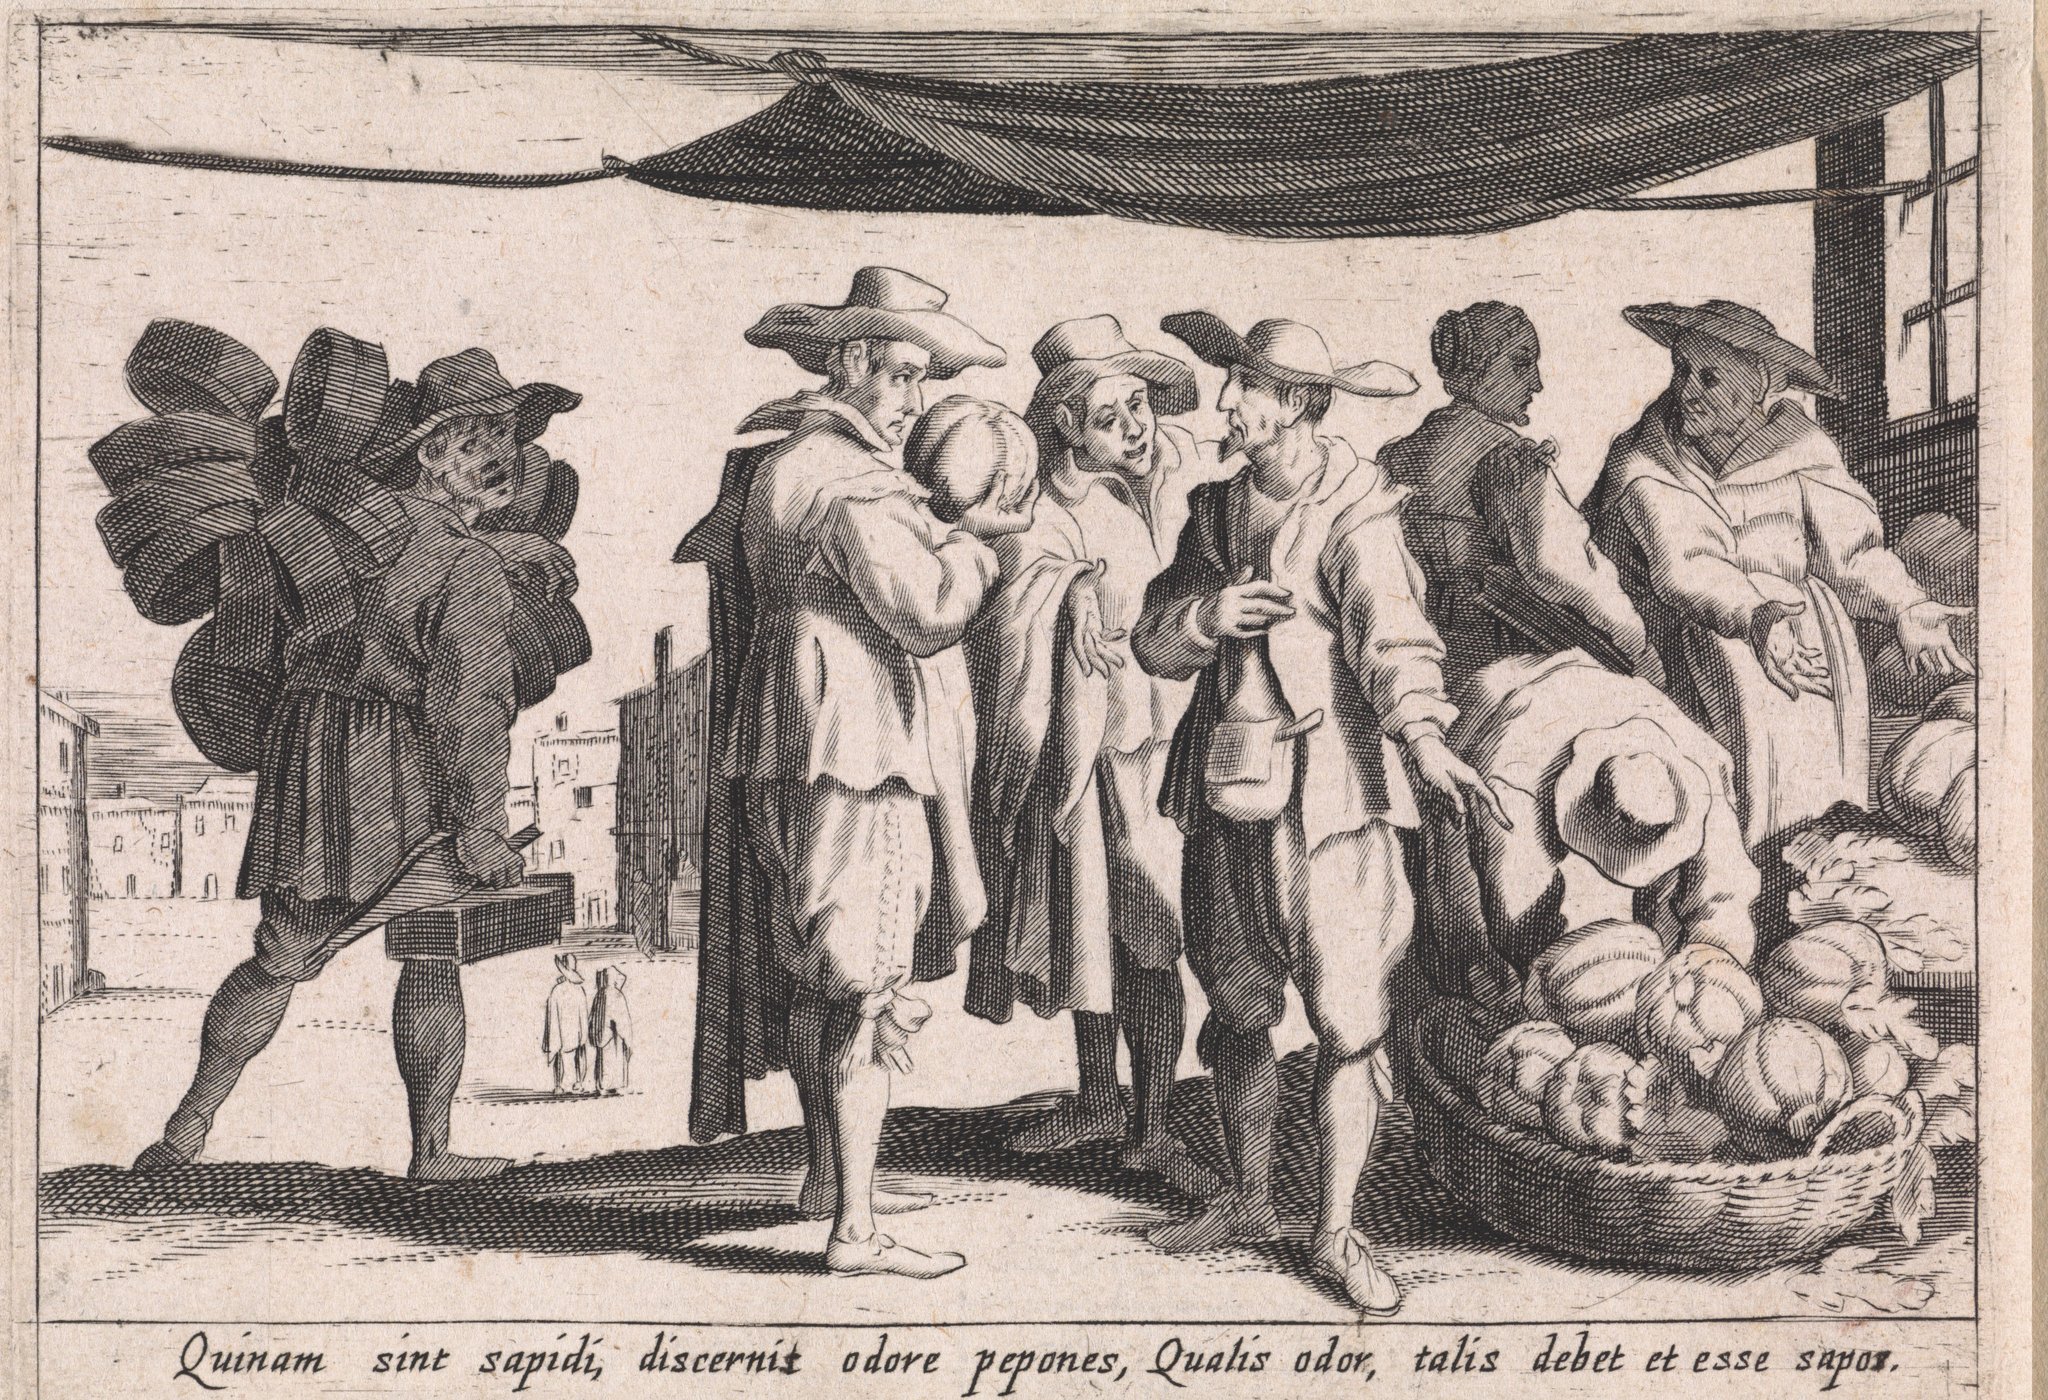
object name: print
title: Pompoenenverkoper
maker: Anonymous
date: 1613-1667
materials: paper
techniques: engraving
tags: fruits: pumpkin, merchant, salesman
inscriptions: collector's mark: Lugt 240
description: Een verkoper prijst zijn waar aan en wijst op een mand die vol ligt met pompoenen. De klant met wie hij in gesprek is ruikt aan een pompoen. Links een dozenverkoper die al zijn waar op zijn rug draagt. In de marge een onderschrift in het Latijn.